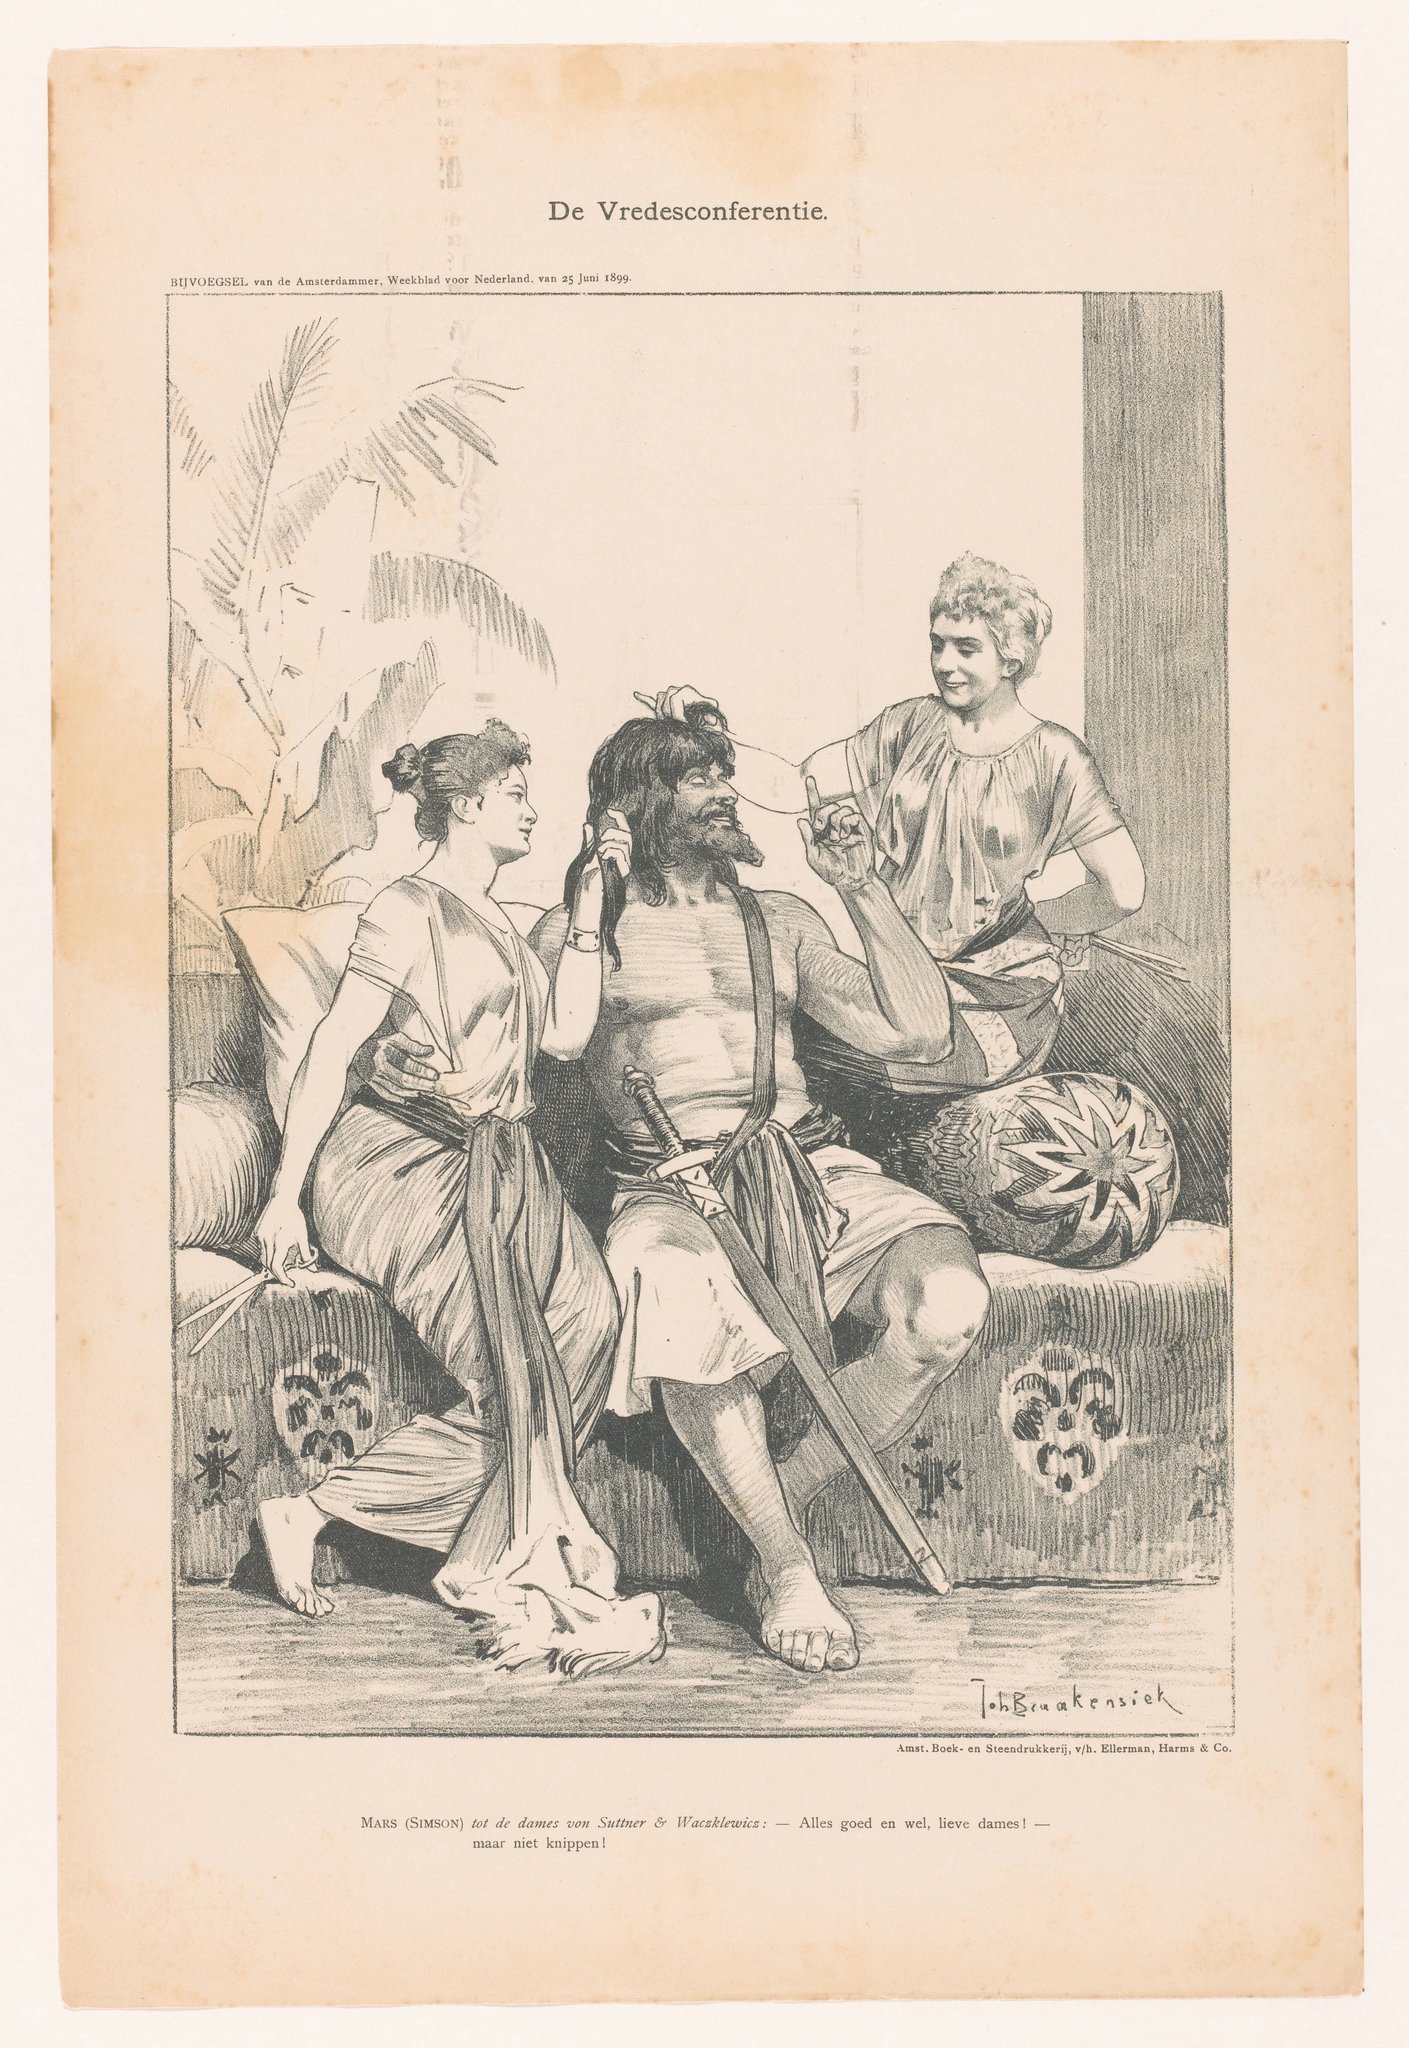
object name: cartoon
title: Nieuwste evolutiën van den in vrijheid gedresseerden Nederlandschen Leeuw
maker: johan braakensiek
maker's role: draughtsman, print maker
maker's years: 1858-1940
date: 1899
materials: paper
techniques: lithograph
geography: amsterdam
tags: historical persons, beasts of prey, predatory animals: lion, political caricatures and satires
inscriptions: date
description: Prent uit het bijvoegsel van: De Amsterdammer. Weekblad voor Nederland, 2 juli 1899.